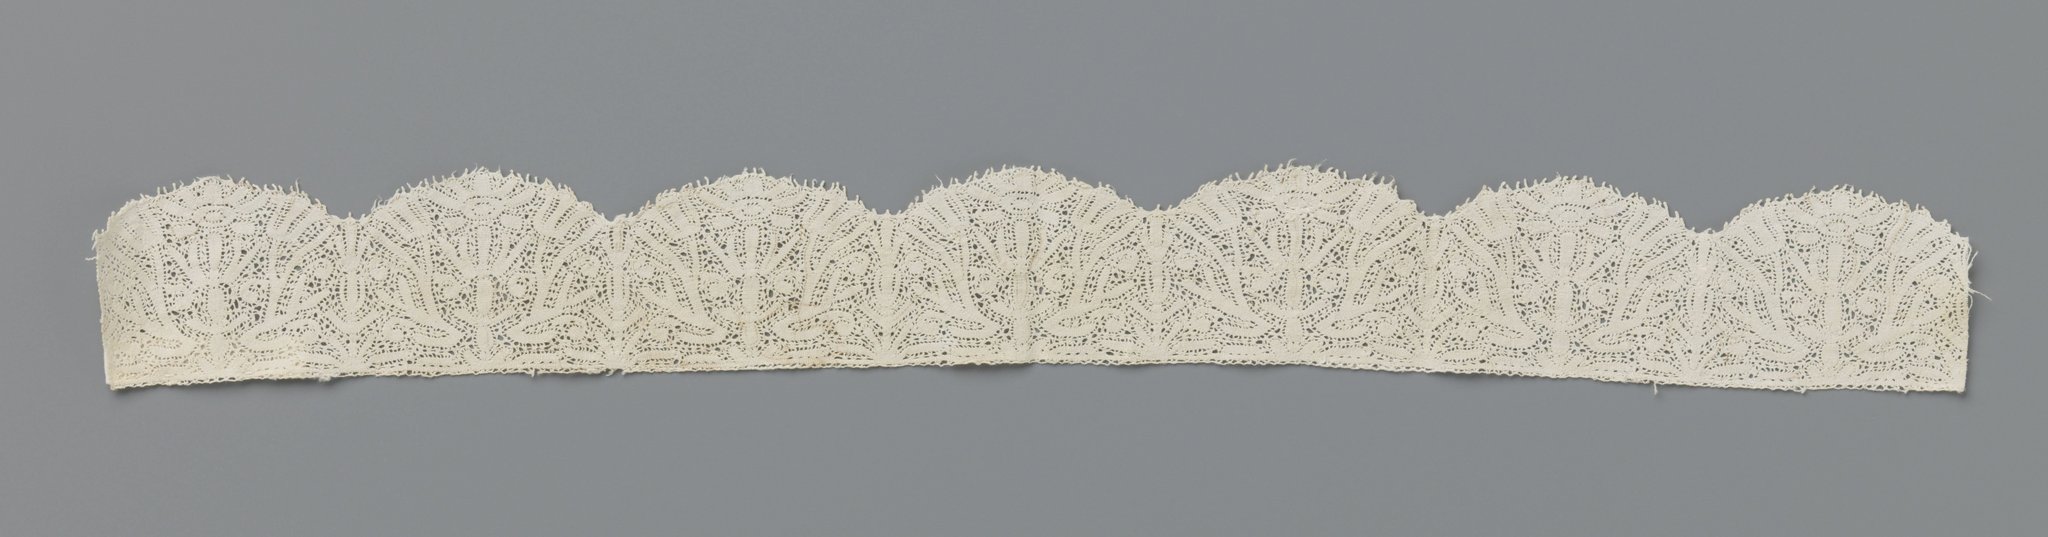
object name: strip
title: Strook kloskant met een door tulpjes geflankeerde margriet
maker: Anonymous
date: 1600-1699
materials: linen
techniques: lace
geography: flanders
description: Strook naturelkleurige kloskant, oudvlaamse kant. Het patroon bestaat uit een zich herhalende symmetrische compositie van een margriet op een rechte steel, die aan weerszijden wordt geflankeerd door een tulpje aan een flauw golvende steel met langgerekte voluutblaadjes. De bloemen hangen vanuit de bovenrand naar beneden en vullen steeds één halfronde ondiepe schulp. Een spaarzaam gebruikte onregelmatige maasgrond verbindt de motieven met elkaar. De motieven zijn gemaakt in linnenslag met opengewerkte randjes. De schulpen zijn gepicoteerd. De bovenzijde is afgewerkt met een rechte rand.